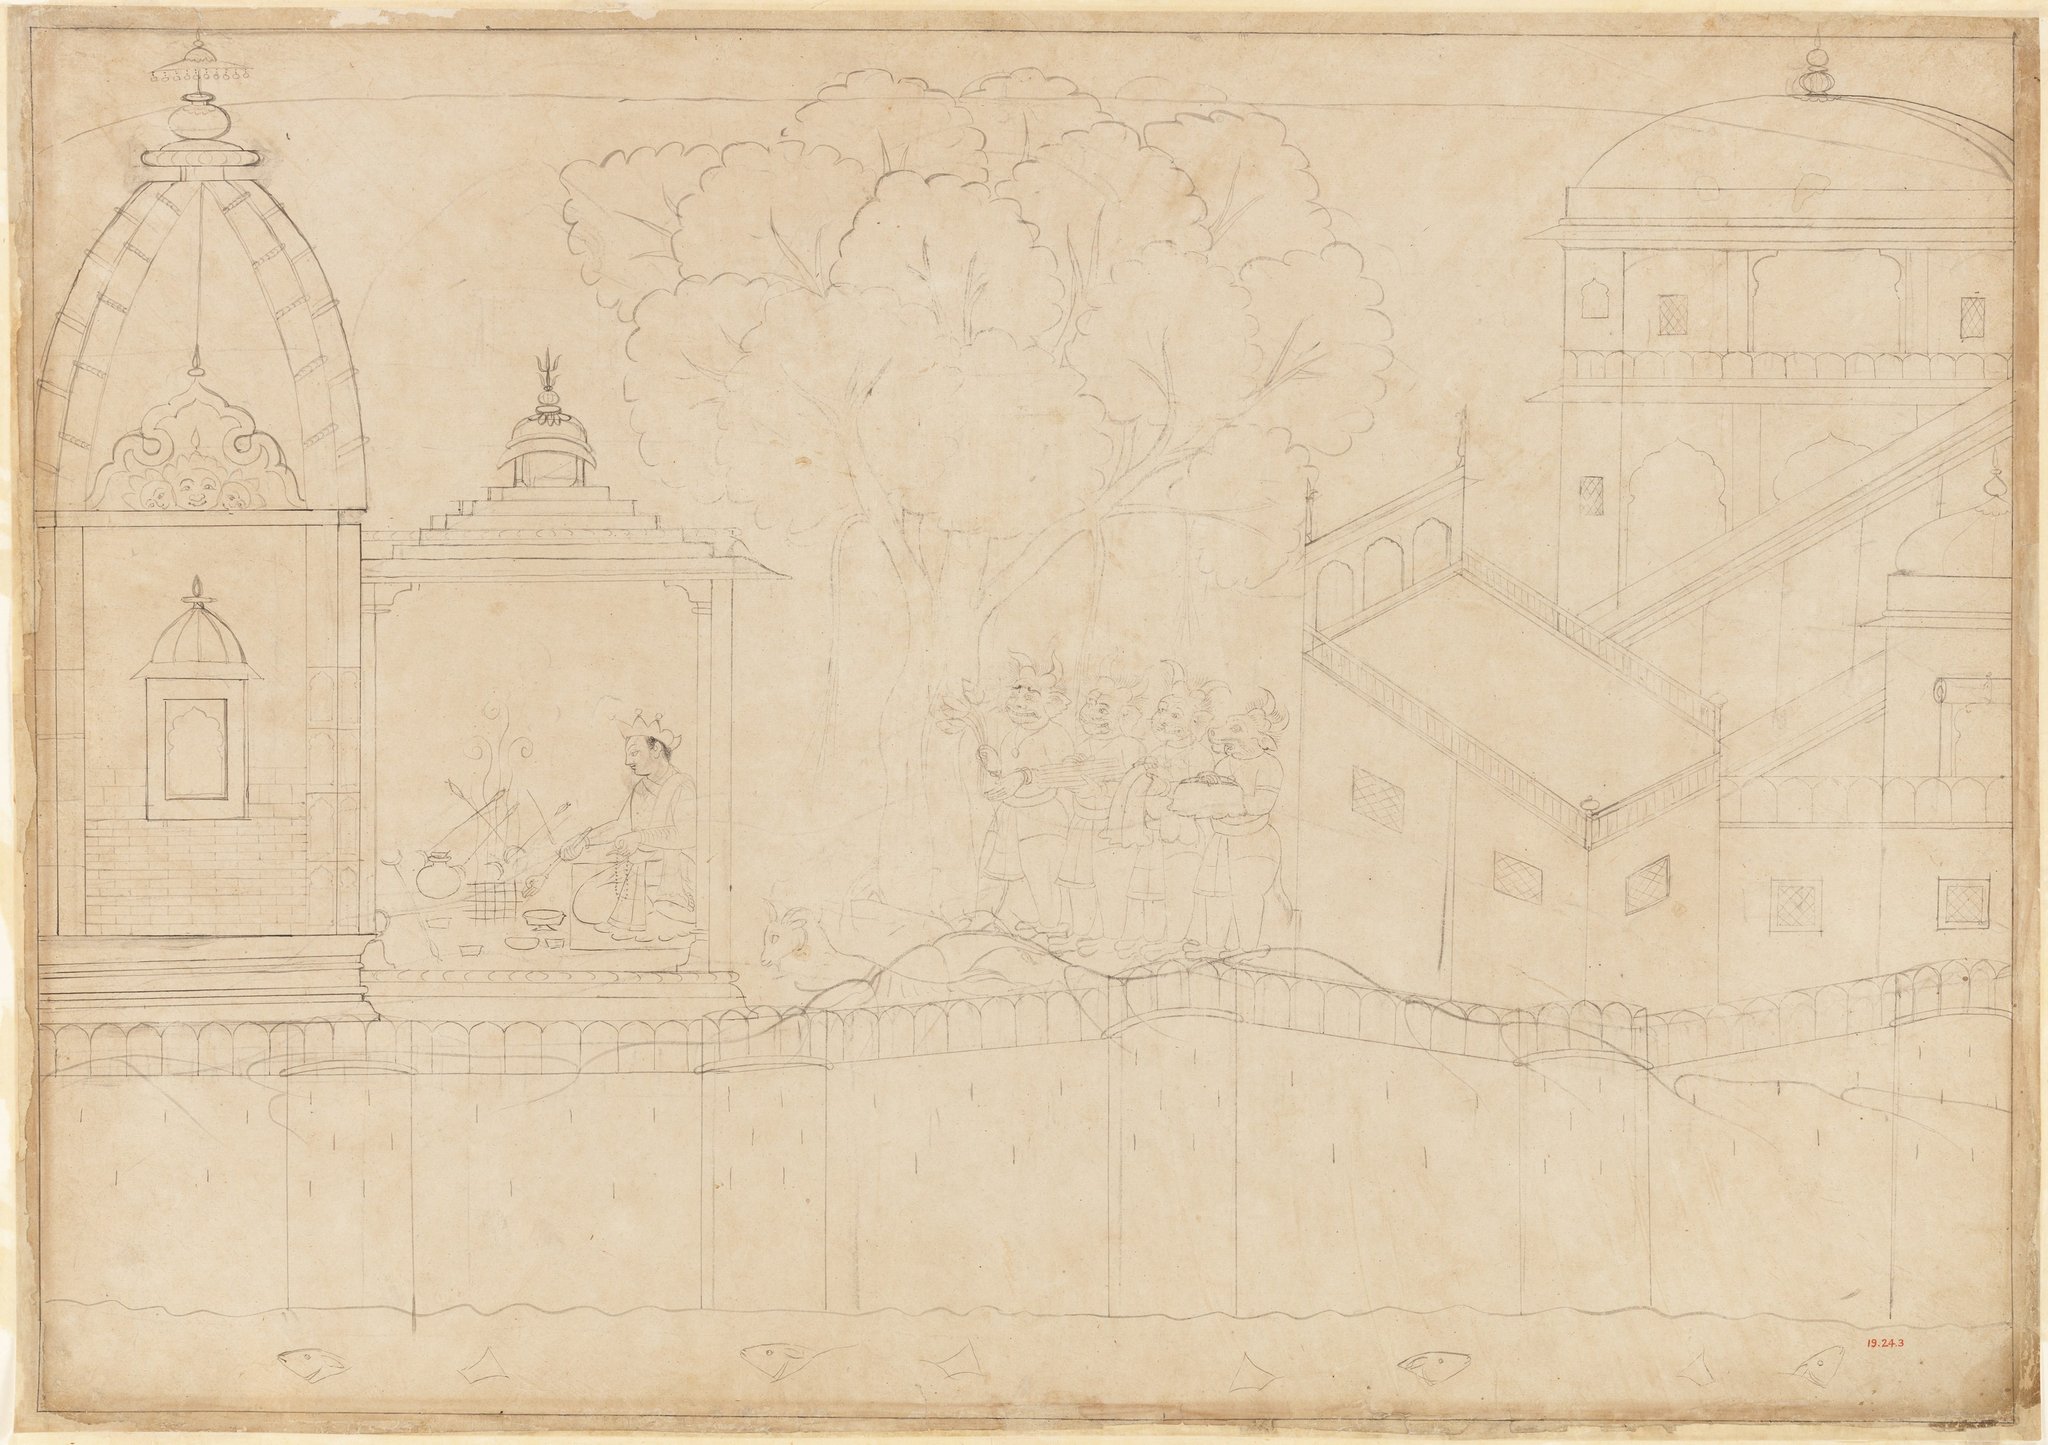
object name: drawing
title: Indrajit Makes Offerings: Folio from the Siege of Lanka series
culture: indian, punjab hills, guler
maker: manaku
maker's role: artist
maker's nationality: indian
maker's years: 1715-1770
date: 1725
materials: ink, paper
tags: altars,men,demons